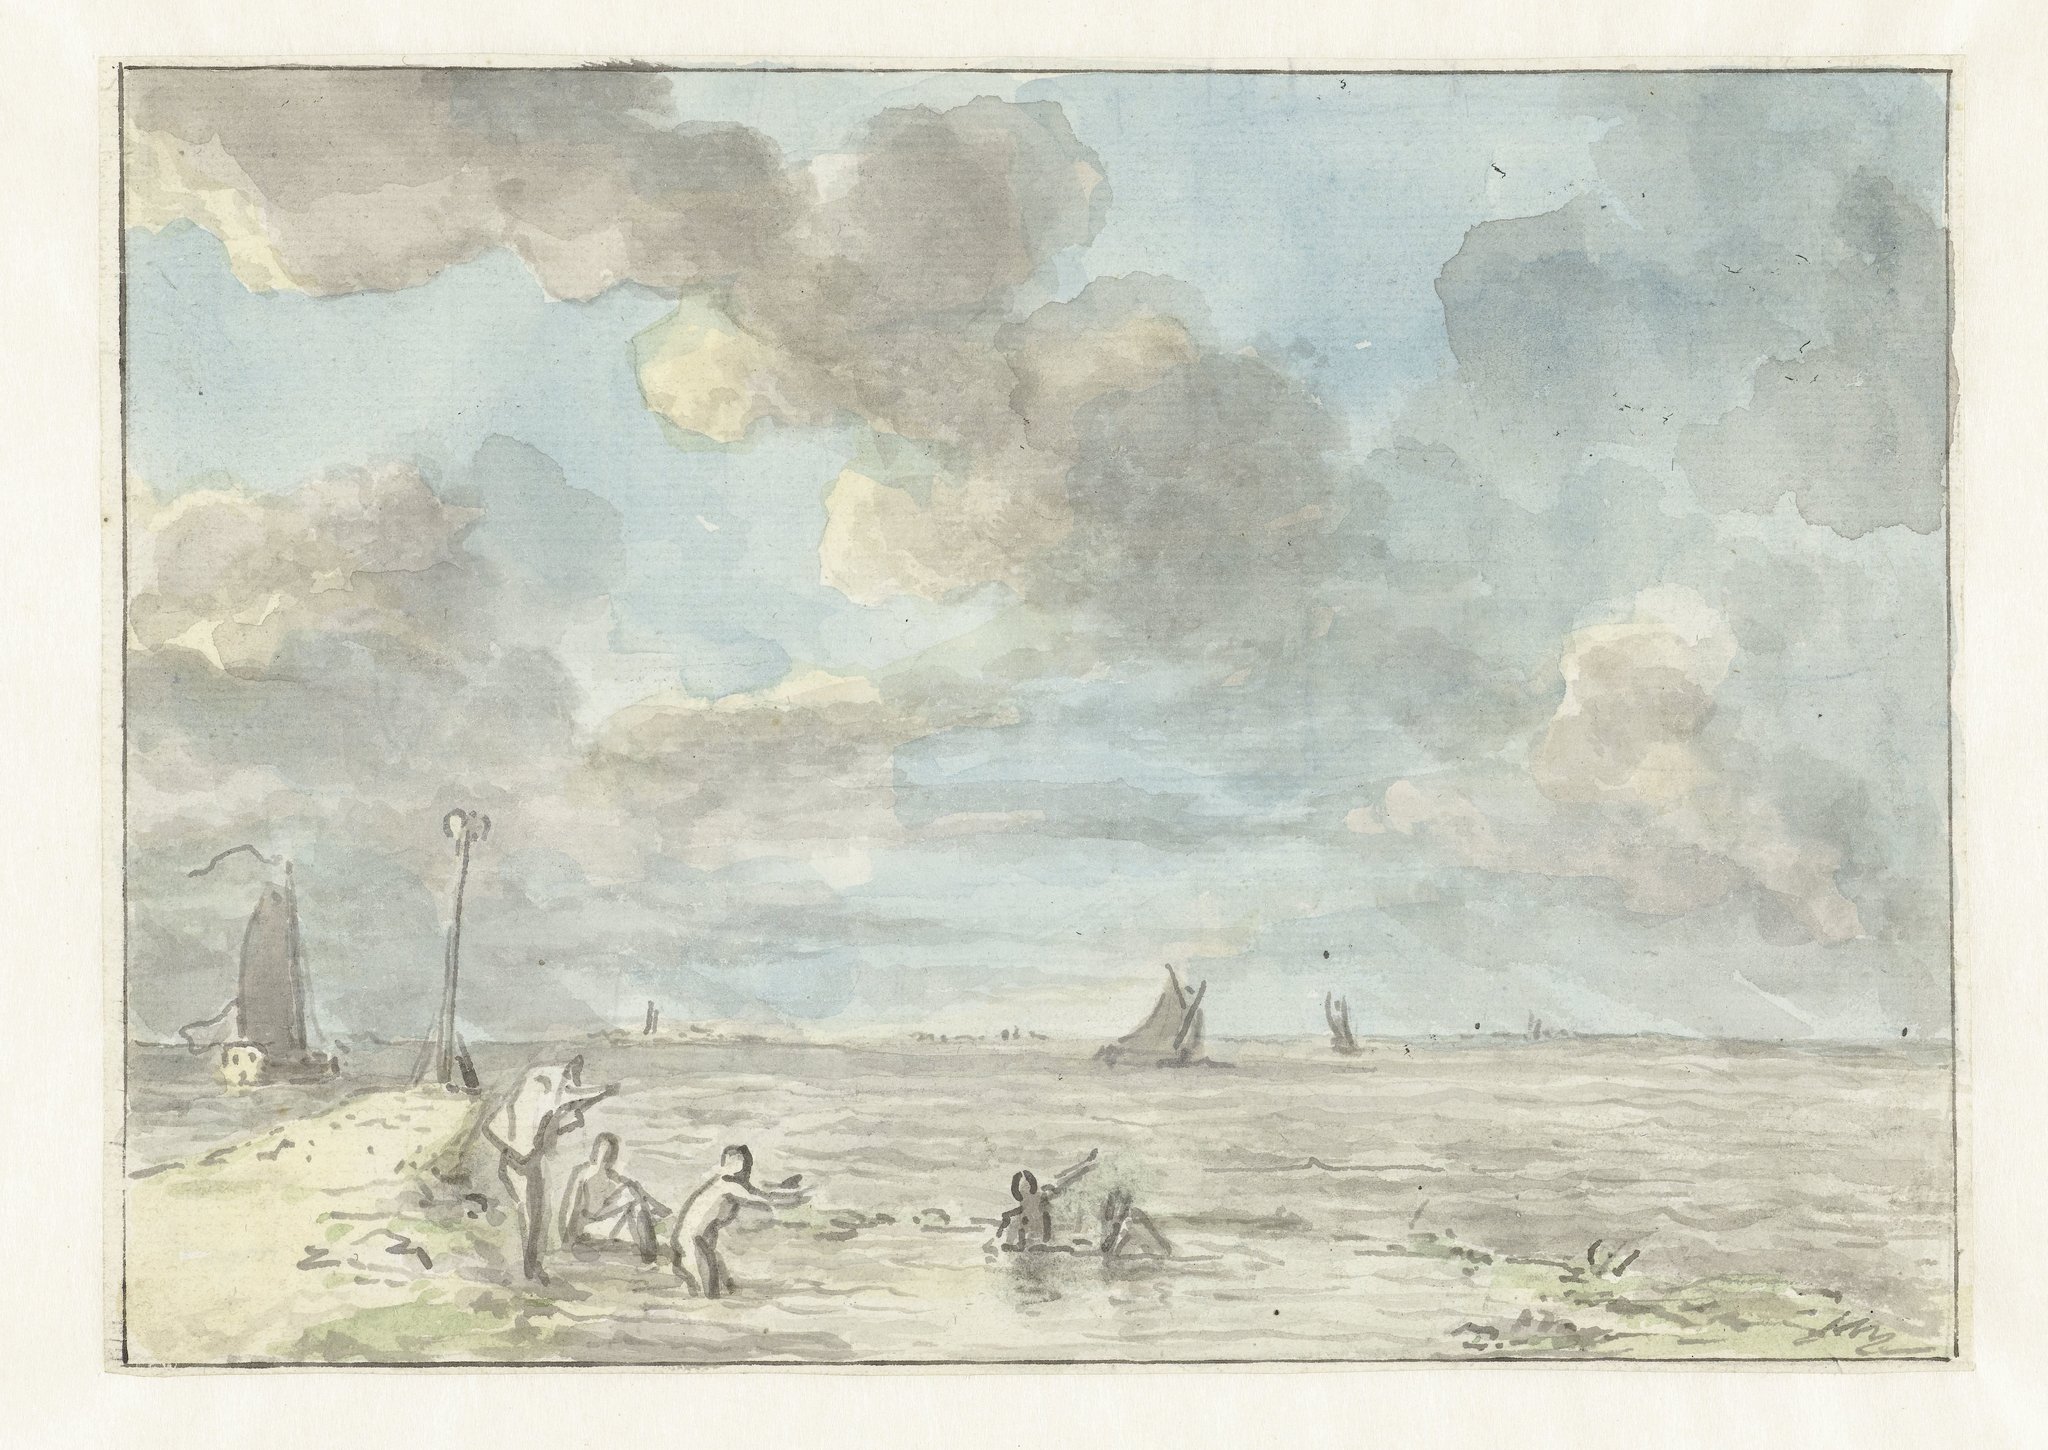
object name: drawing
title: De Baak, een badplaats aan het IJ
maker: jurriaan andriessen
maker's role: draughtsman, painter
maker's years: 1742-1819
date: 1803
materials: ink, paper, pencil, watercolor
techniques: brush, pen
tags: swimming (sport), taking a bath - aa - in the open air, in or beside the water (on the beach), amsterdam